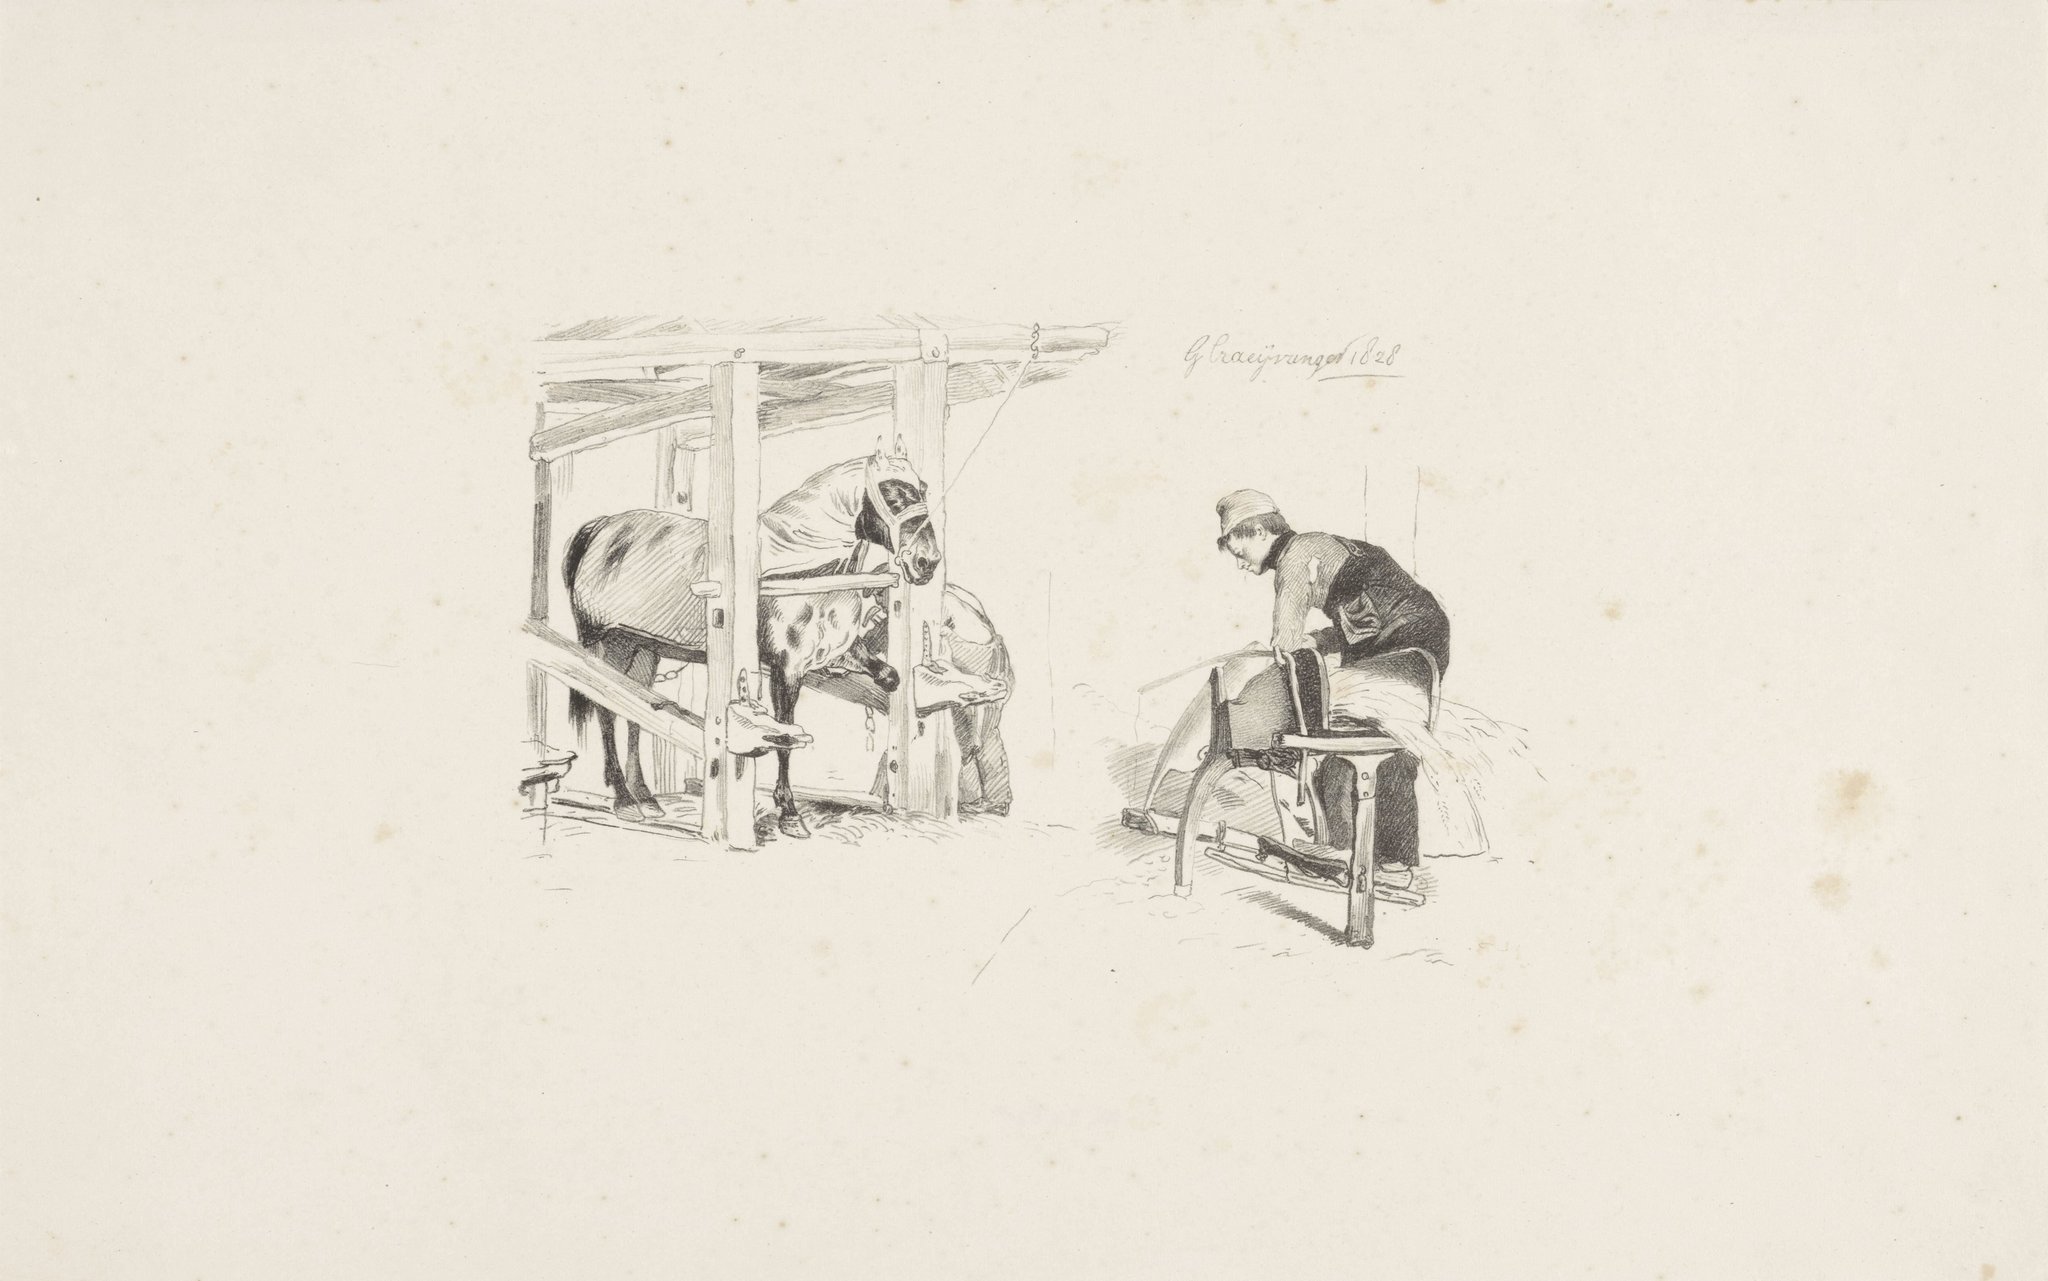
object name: print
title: Beesten Studien naar het Leven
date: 1828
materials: paper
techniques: lithograph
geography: netherlands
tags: farrier, shoeing-smith, threshing, binding ~ harvest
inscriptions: date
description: Waarschijnlijk is dit een prent voor: 'Beesten Studien naar het Leven op steen gebragt door G. Craeyvanger'. Amsterdam: Francois Buffa & Zoonen, 1828. Zie Swillens in Jaarboek Oud Utrecht. Volgens Swillens gedrukt door Ambroise Jobard. In Lijst van kunstwerken door beoefenaars en verzamelaars bijeengebragt, om verloot te worden ten behoeve van het vaderland; tentoongesteld te Amsterdam, in het nationale geregtshof, Amsterdam (C.A. Spin) 1831, p. 31, nr. 700 vermeld als uitgave van Daiwaille en Veldhuijzen. Daiwaille had eerder samengewerkt met Ambroise Jobard.